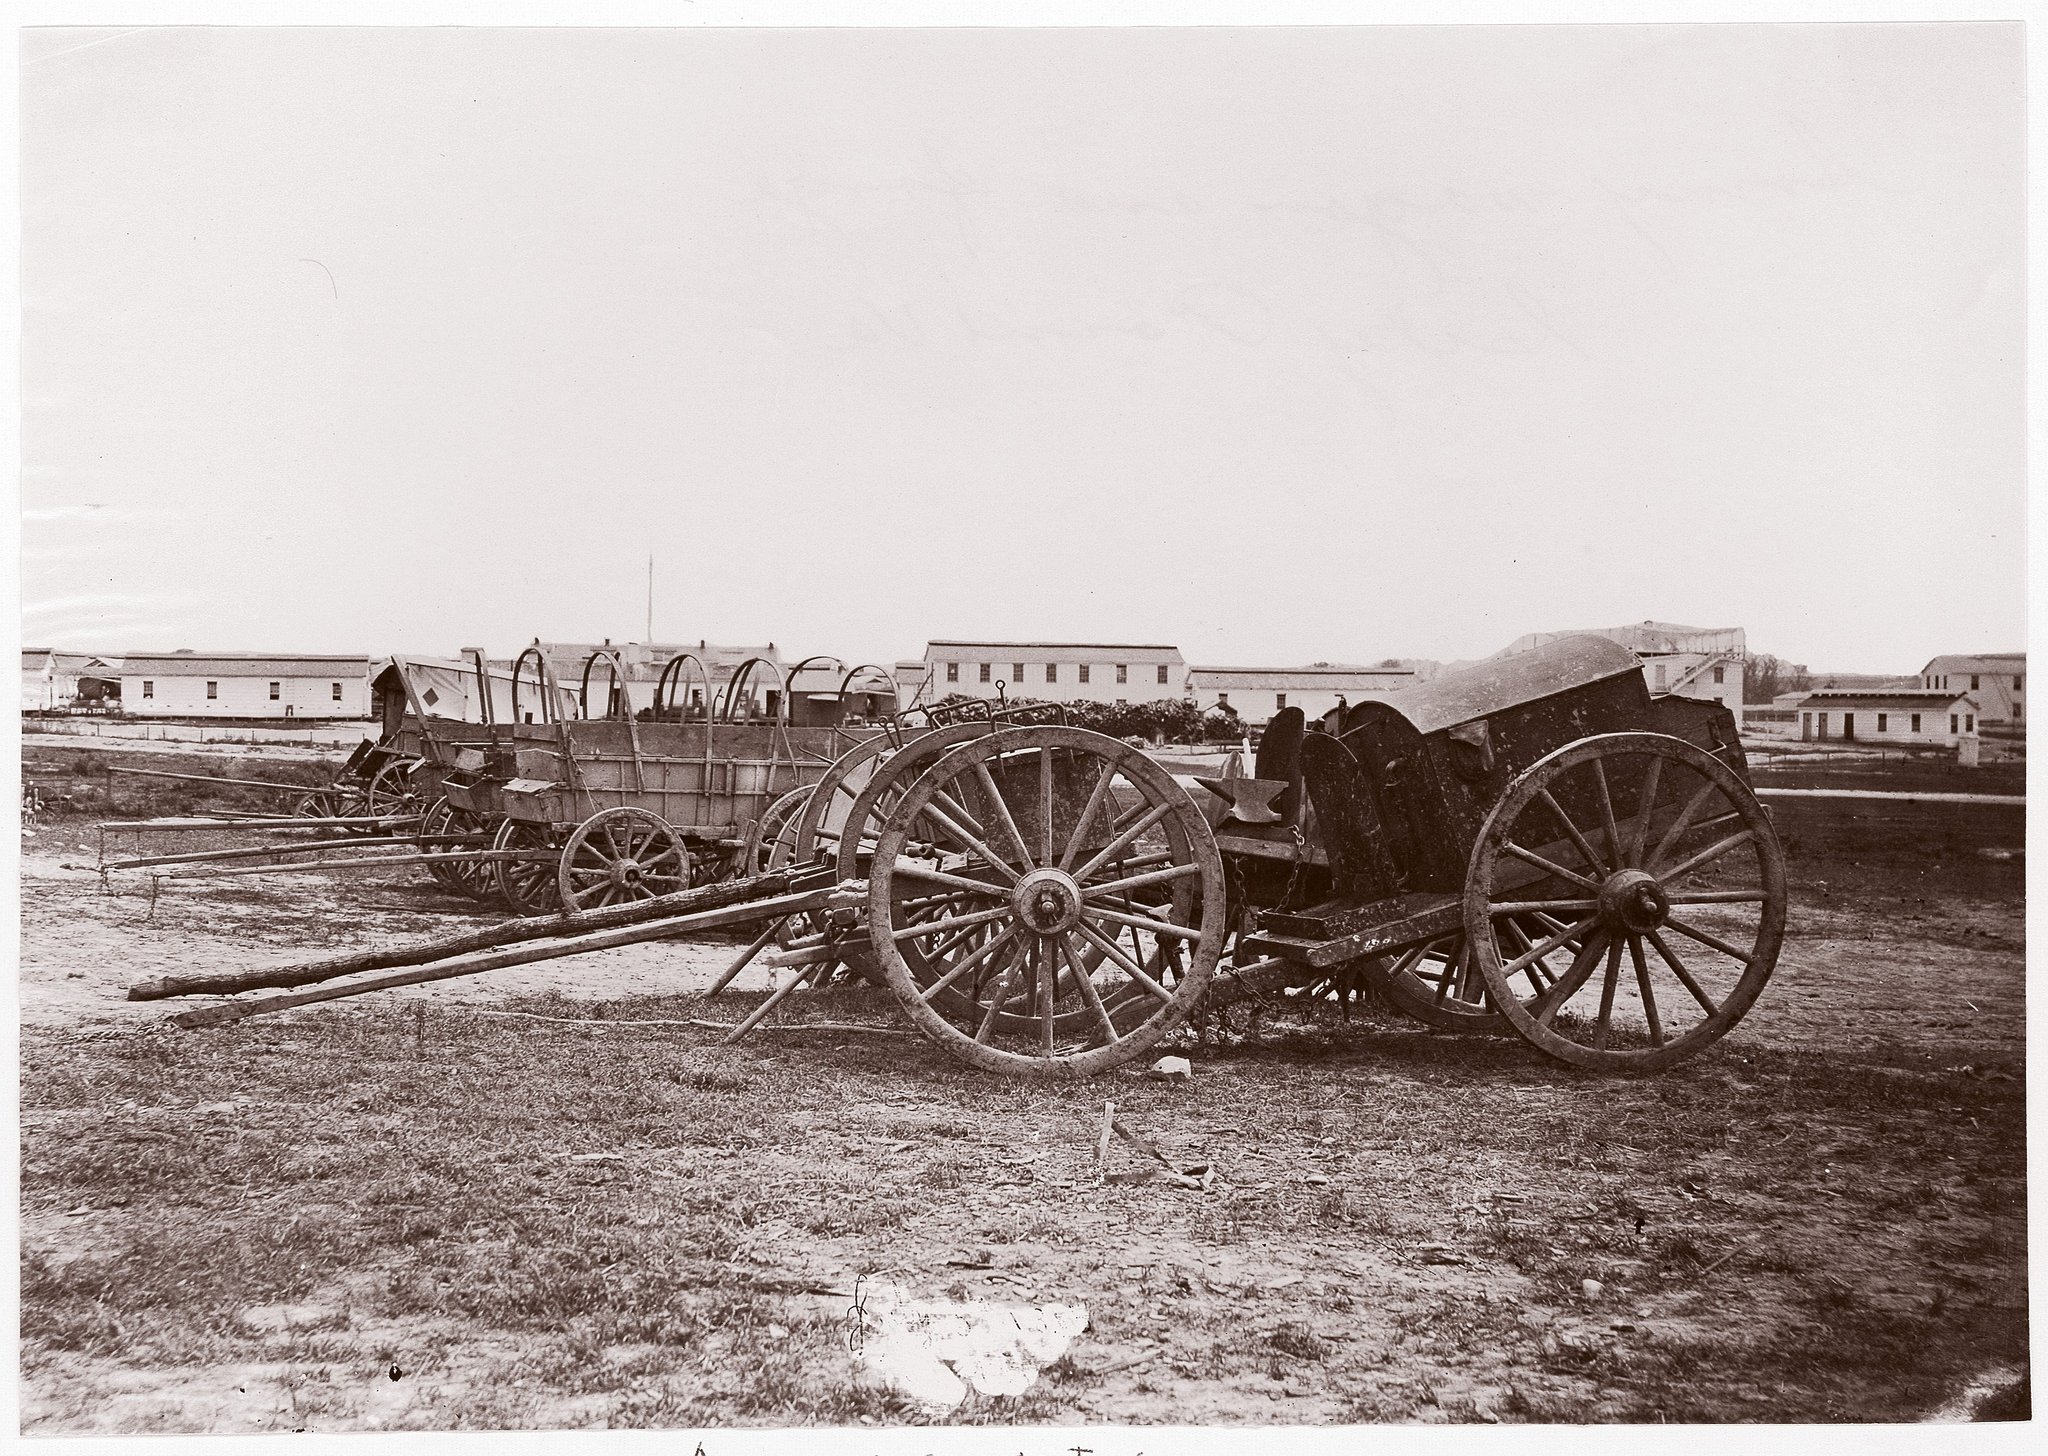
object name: photograph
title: [Army Wagons and Forge, City Point, Virginia]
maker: andrew joseph russell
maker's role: artist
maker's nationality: american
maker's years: 1830-1902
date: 1861-1865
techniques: albumen silver print, glass negative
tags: american civil war,wagons